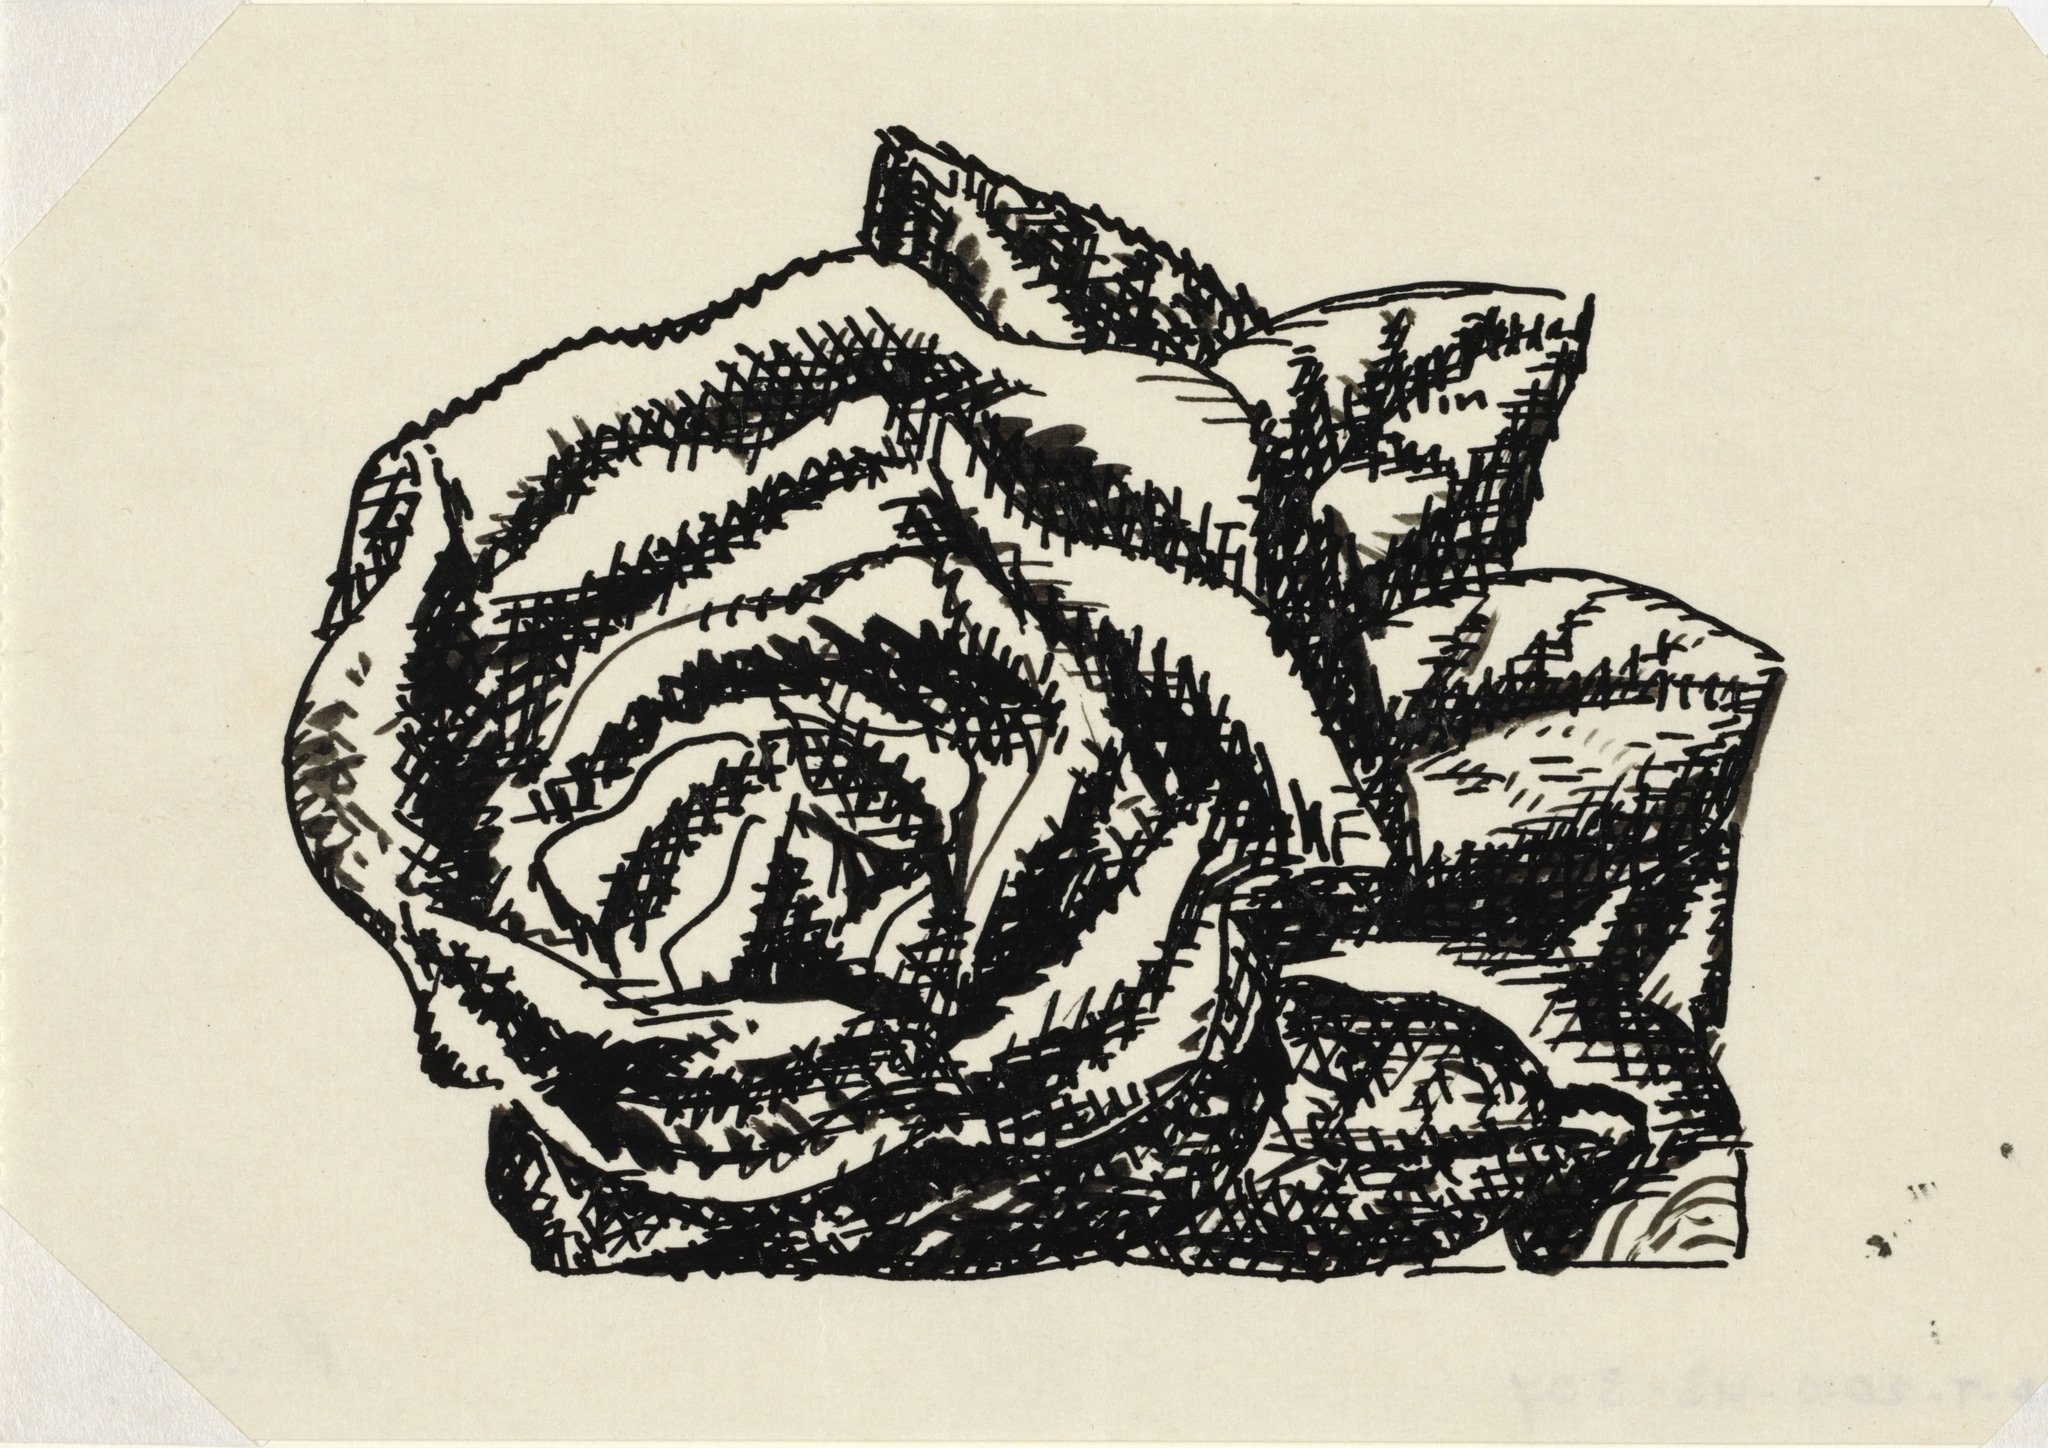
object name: drawing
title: Zonder titel (roos)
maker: leo gestel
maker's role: draughtsman, print maker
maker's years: 1881-1941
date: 1935-1936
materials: ink, paper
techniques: pen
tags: flowers: rose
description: De huidige titels zijn door het museum toegekend bij gebrek aan informatie over een originele titel.